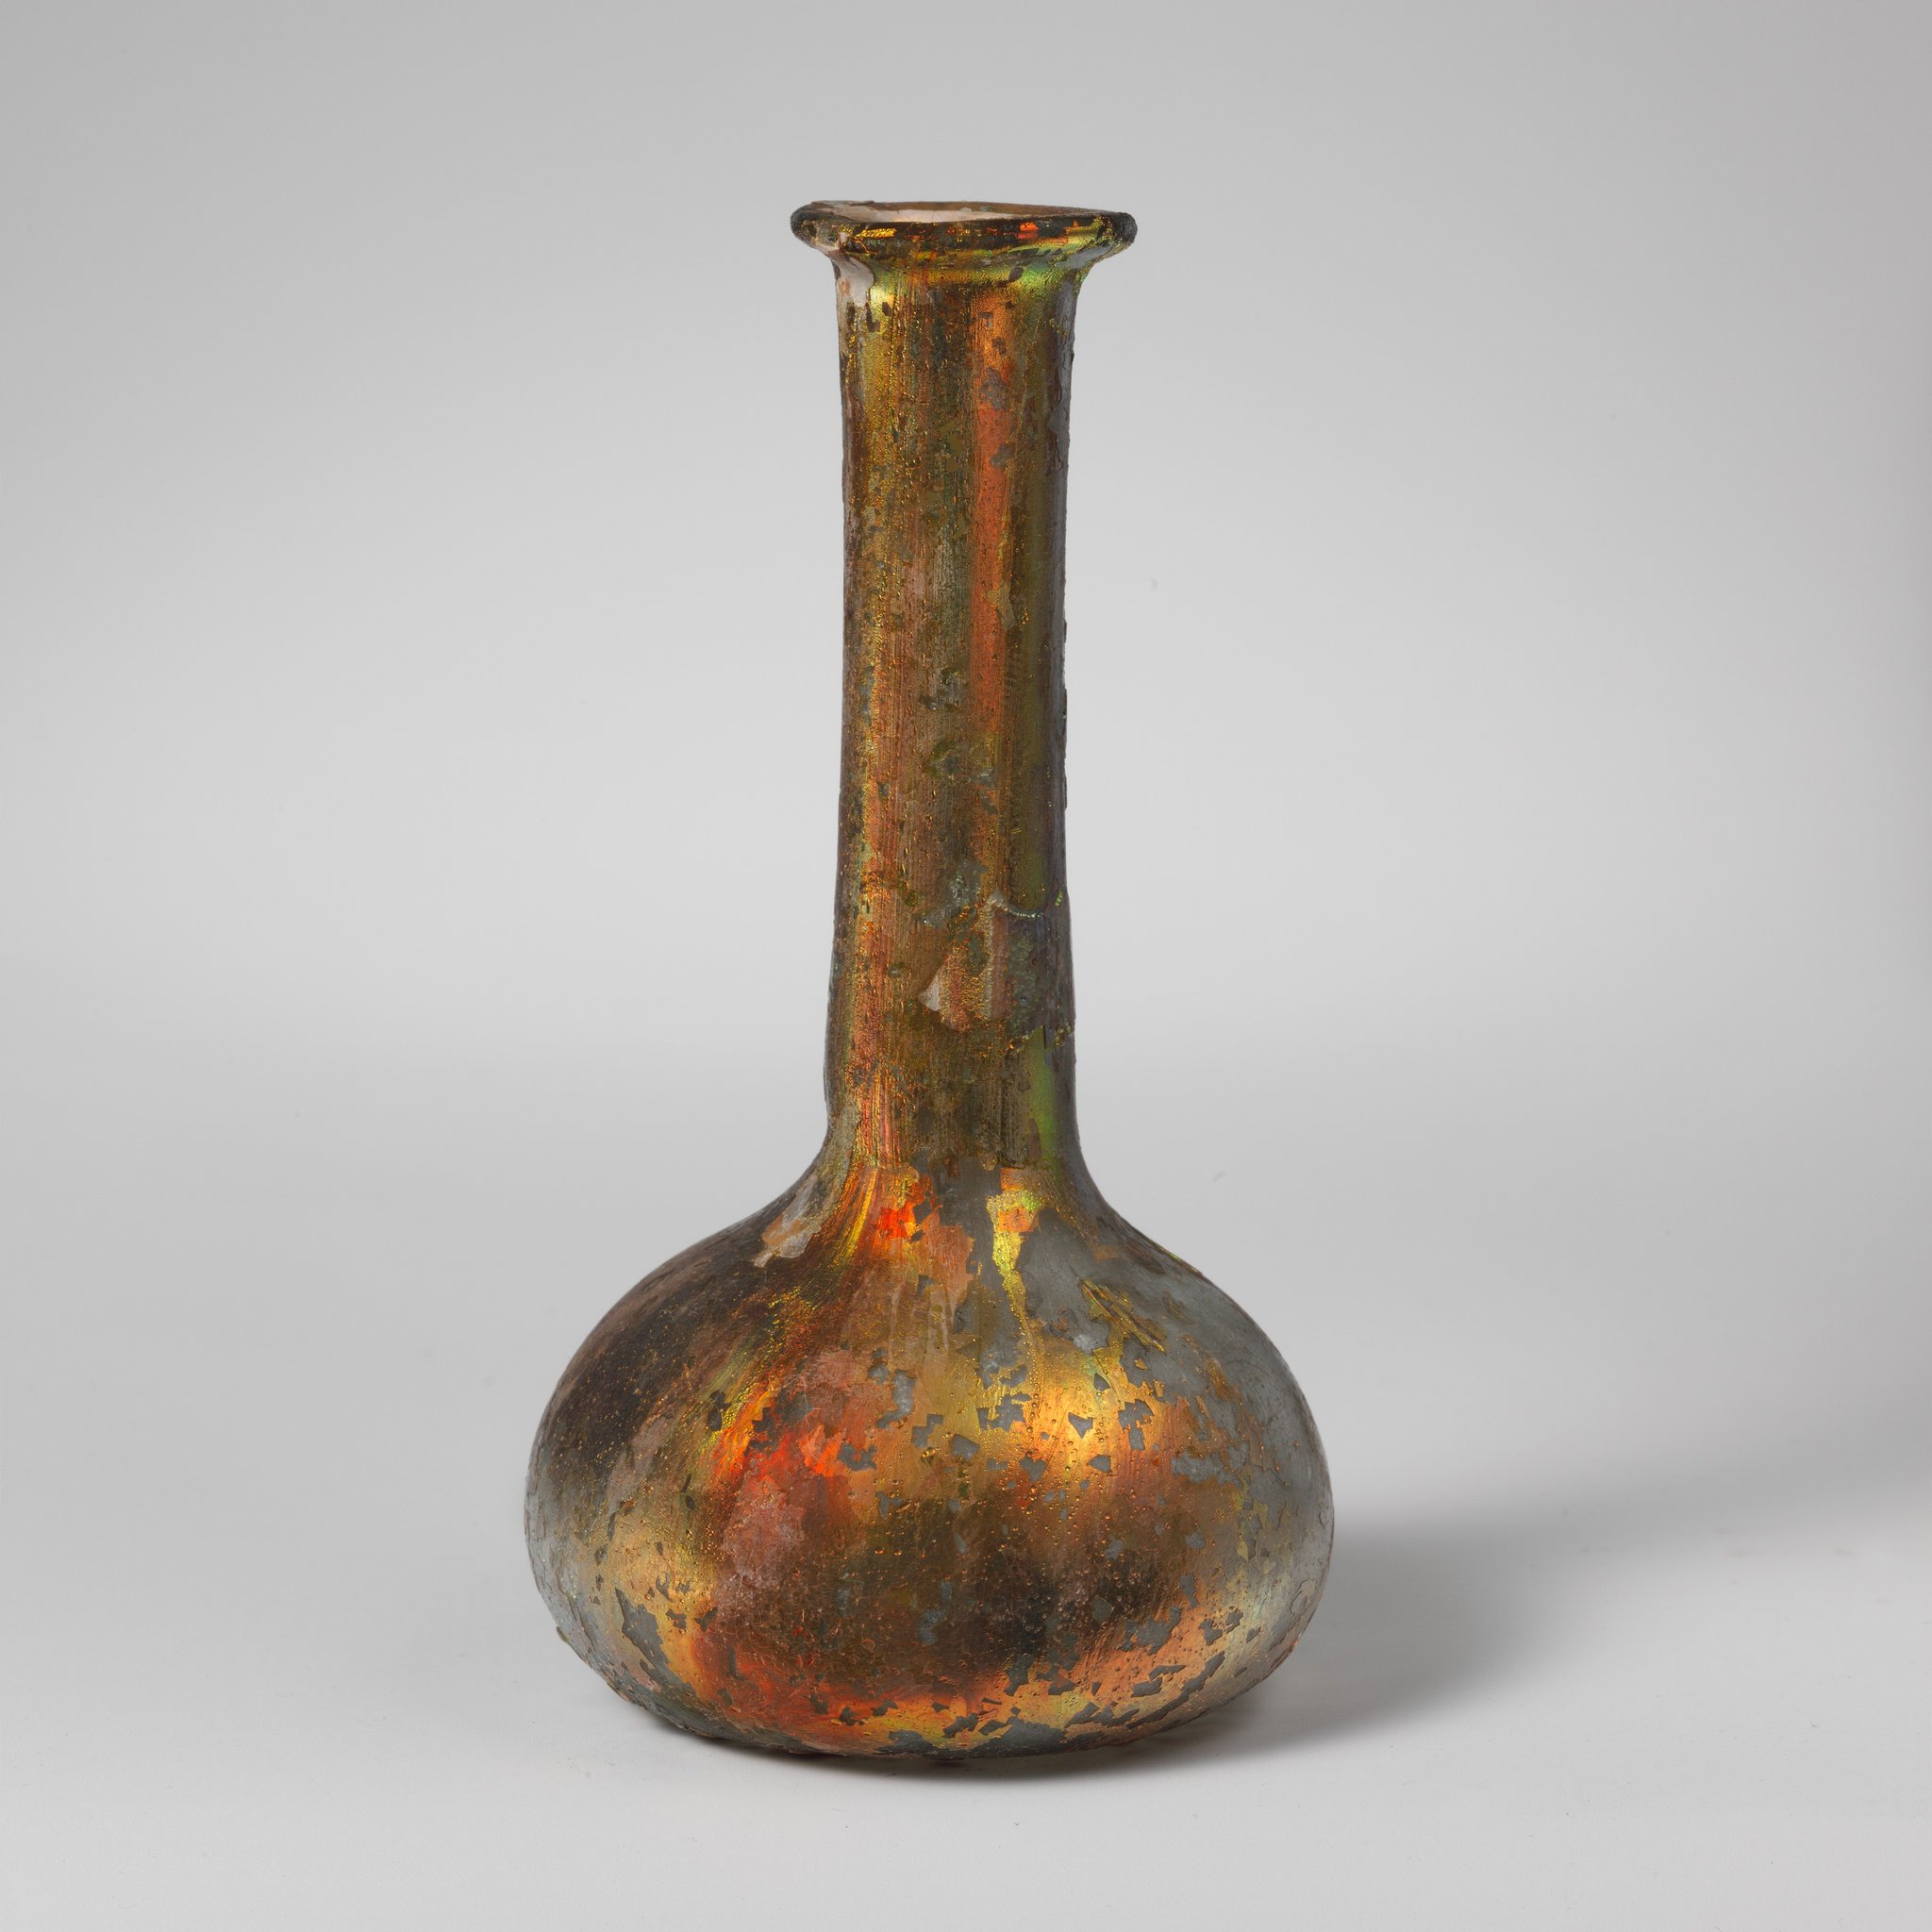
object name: perfume bottle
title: Glass perfume bottle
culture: roman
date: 67-166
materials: glass